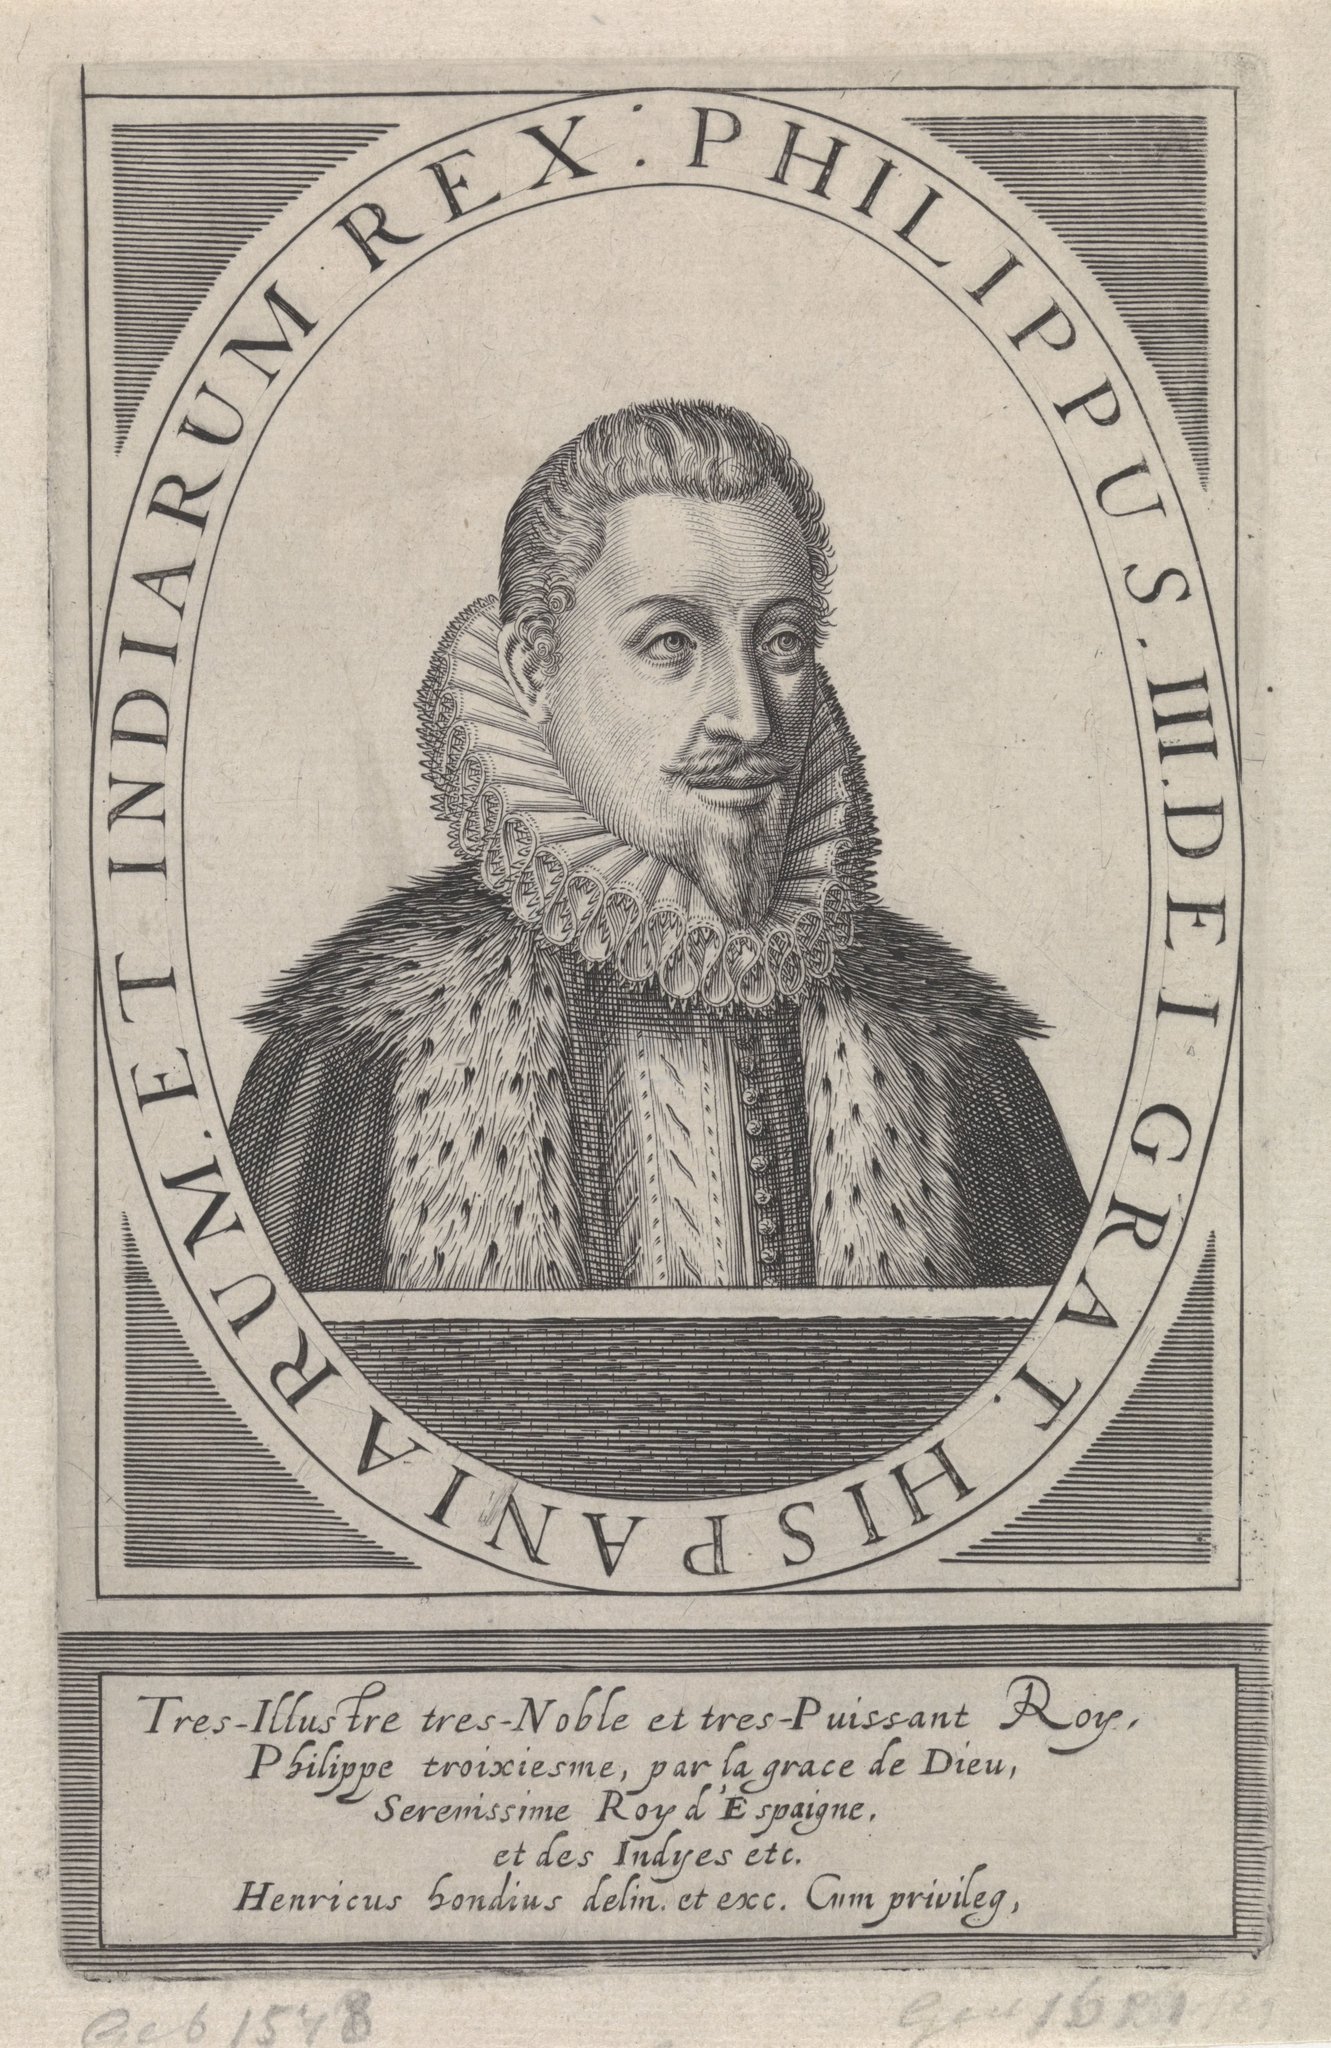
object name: print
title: Portret van Filips III, koning van Spanje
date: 1608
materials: paper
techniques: engraving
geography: the hague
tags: filips iii (koning van spanje)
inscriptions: collector's mark: Lugt 2228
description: Buste naar rechts van Filips III, koning van Spanje, in een ovale omlijsting, waarop een randschrift met zijn naam en titel in het Latijn. Onder het portret vier regels in het Frans. Prent uit een serie van veertig portretten van vredestichters in de Nederlanden.